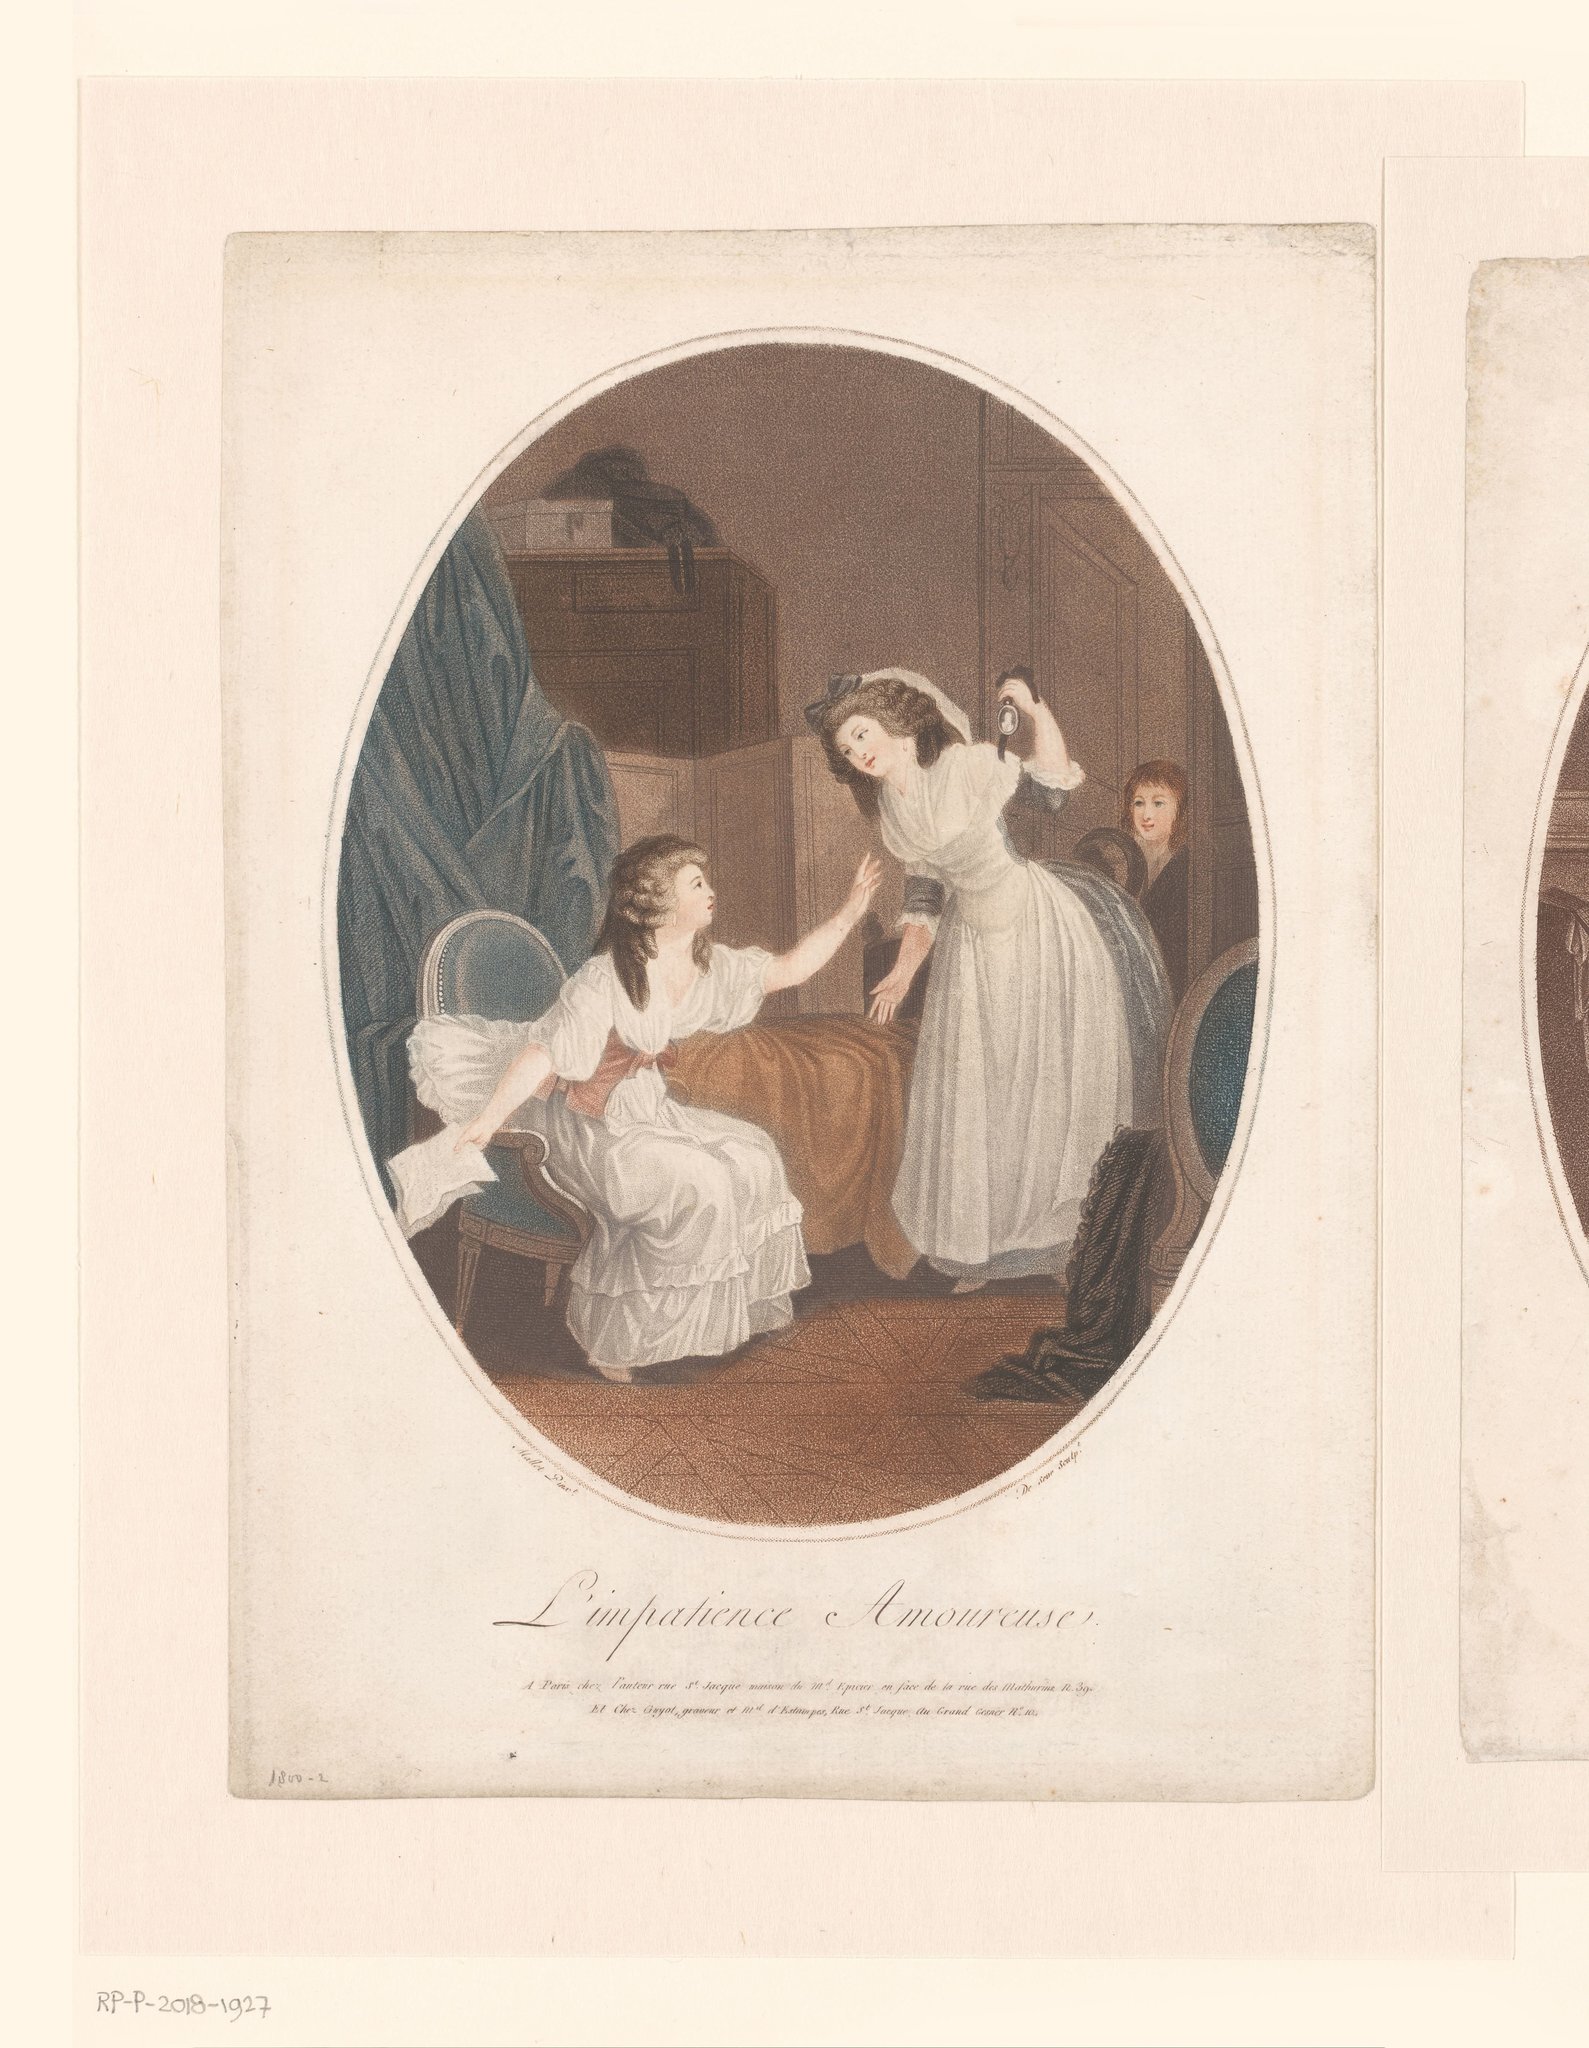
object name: print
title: Interieur met twee elegante dames, in de deuropening een jongen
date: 1800-1830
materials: paper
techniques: etching, lithography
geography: paris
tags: interior of the house, adult woman (+ two persons)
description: Een zittende dame in een stoel strekt haar hand uit naar een medaillon dat de andere dame omhoog houdt.